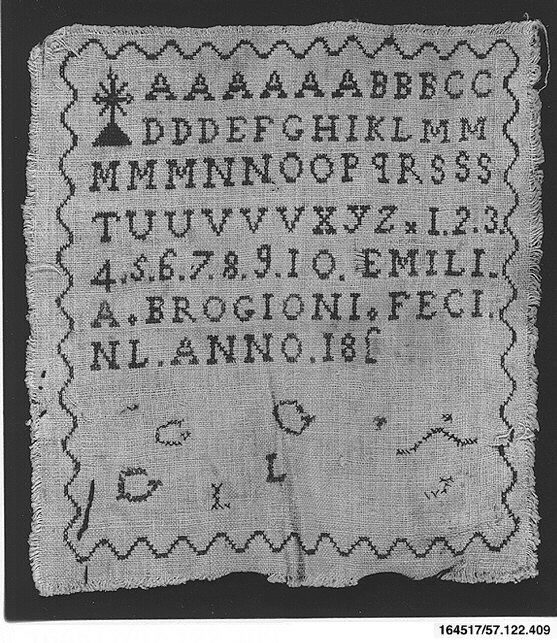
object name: sampler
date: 1801-1900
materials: cotton, linen